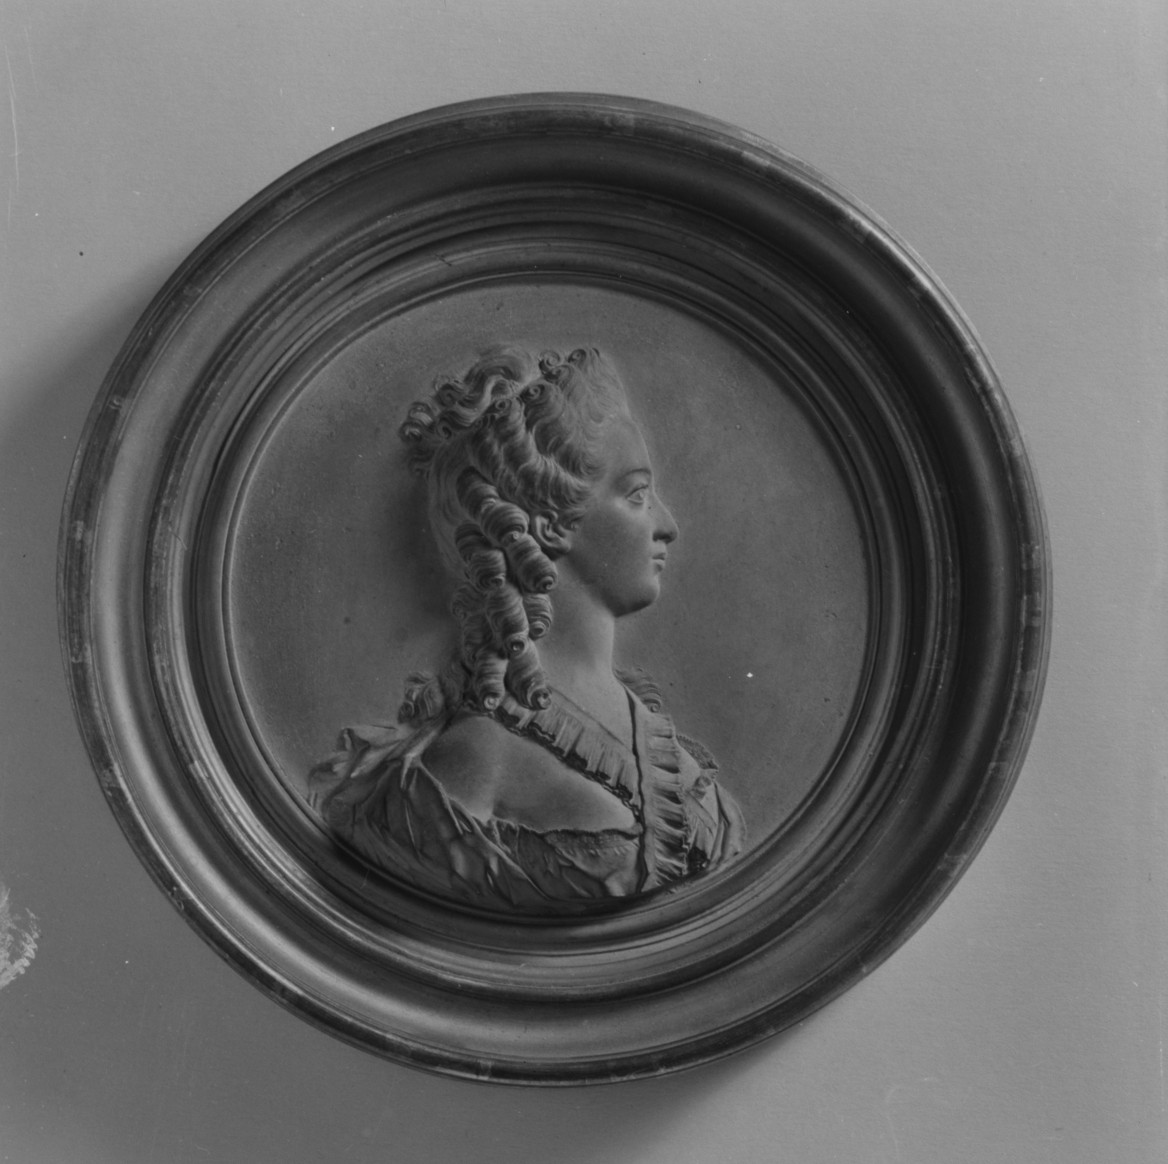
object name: medallion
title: Suzanne-Elisabeth-Françoise de Jarente de La Reynière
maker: jean-baptiste nini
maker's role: artist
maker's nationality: italian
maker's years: 1717-1786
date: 1769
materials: gilt, terracotta, wood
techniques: casting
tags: profiles,women